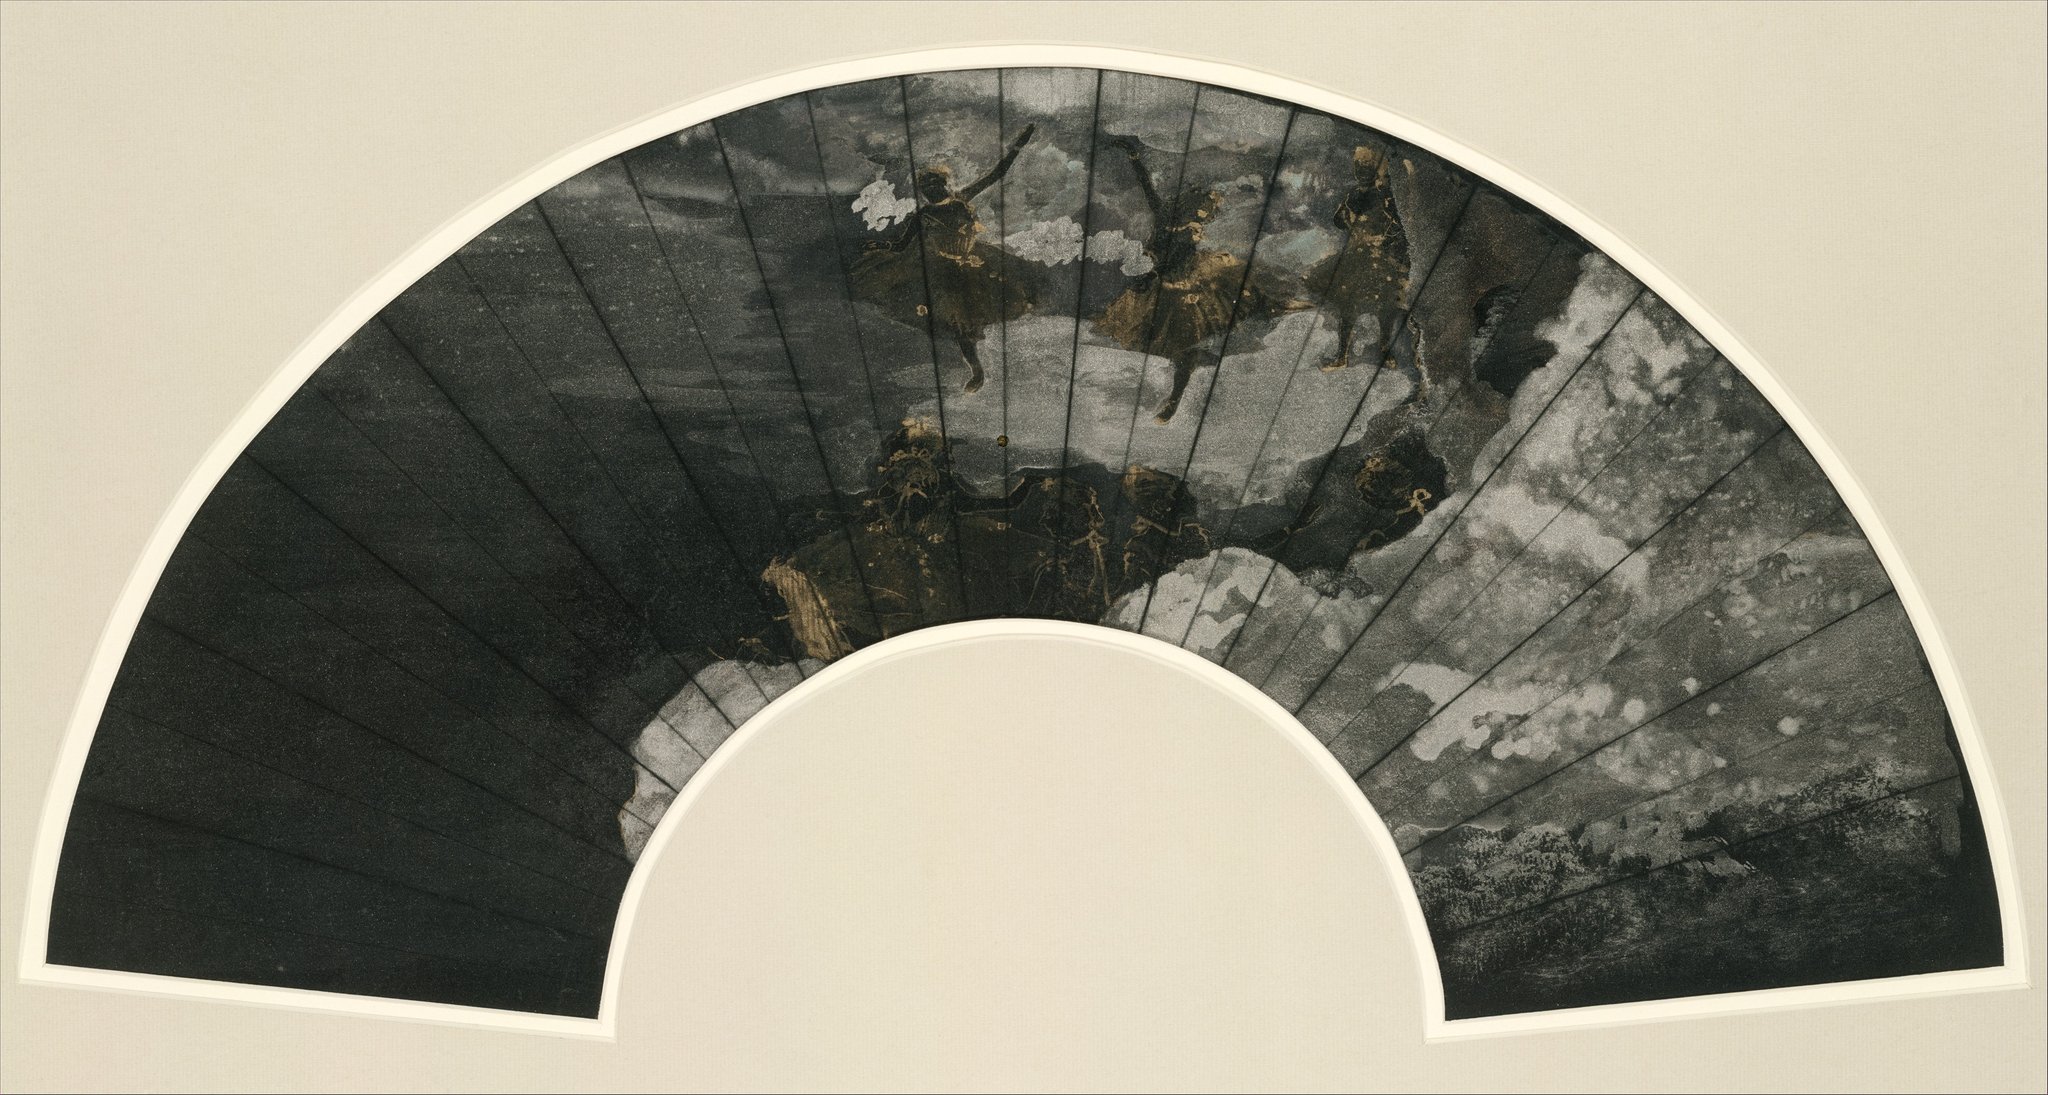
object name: drawing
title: Fan Mount: The Ballet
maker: edgar degas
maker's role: artist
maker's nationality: french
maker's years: 1834-1917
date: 1879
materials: paint, silk, watercolor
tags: women,dancing,ballet